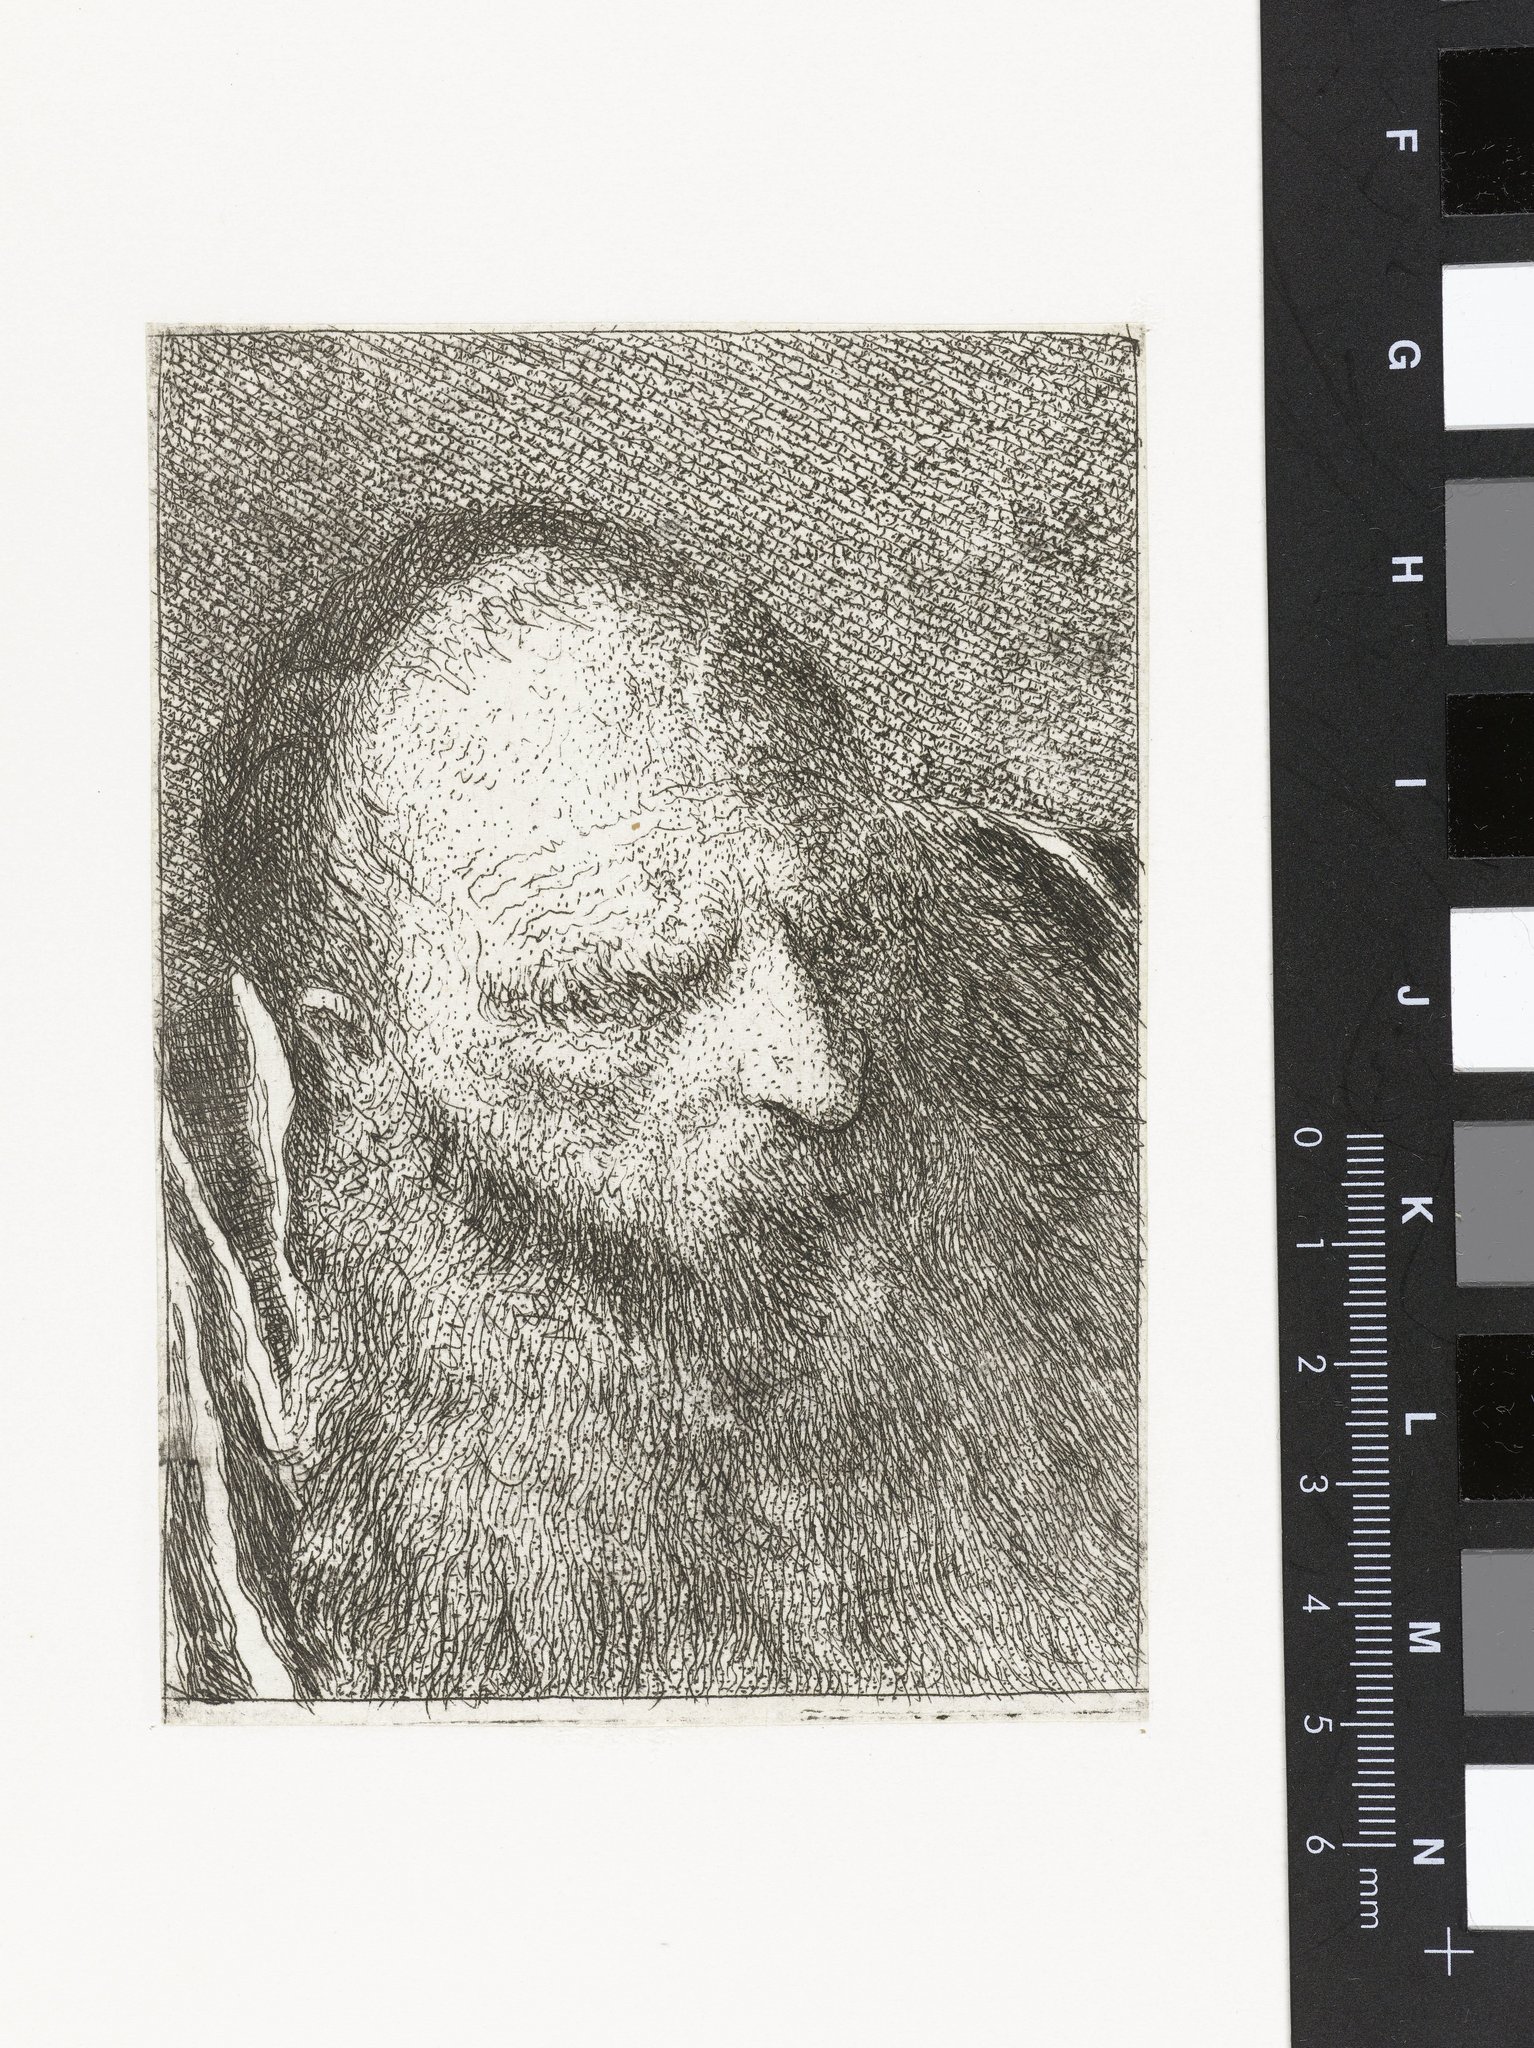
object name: print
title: Raccolta di Teste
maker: giovanni domenico tiepolo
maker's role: draughtsman, print maker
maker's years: 1727-1804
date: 1771-1774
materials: paper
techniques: etching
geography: venice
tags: person with big beard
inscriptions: collector's mark: Lugt 2228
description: Prent uit serie Verzameling hoofden (Raccolta di teste). Giovanni Domenico Tiepolo vervaardigde in de winter van 1757-1758 en in de periode van 1771-1774 deze hoofden naar schilderijen en tekeningen van Giovanni Battista Tiepolo. De eerste uitgave verscheen in 1774 in twee delen met elk dertig prenten. Deze prent werd in de tweede staat met serienummer 6 opgenomen in deel 2.